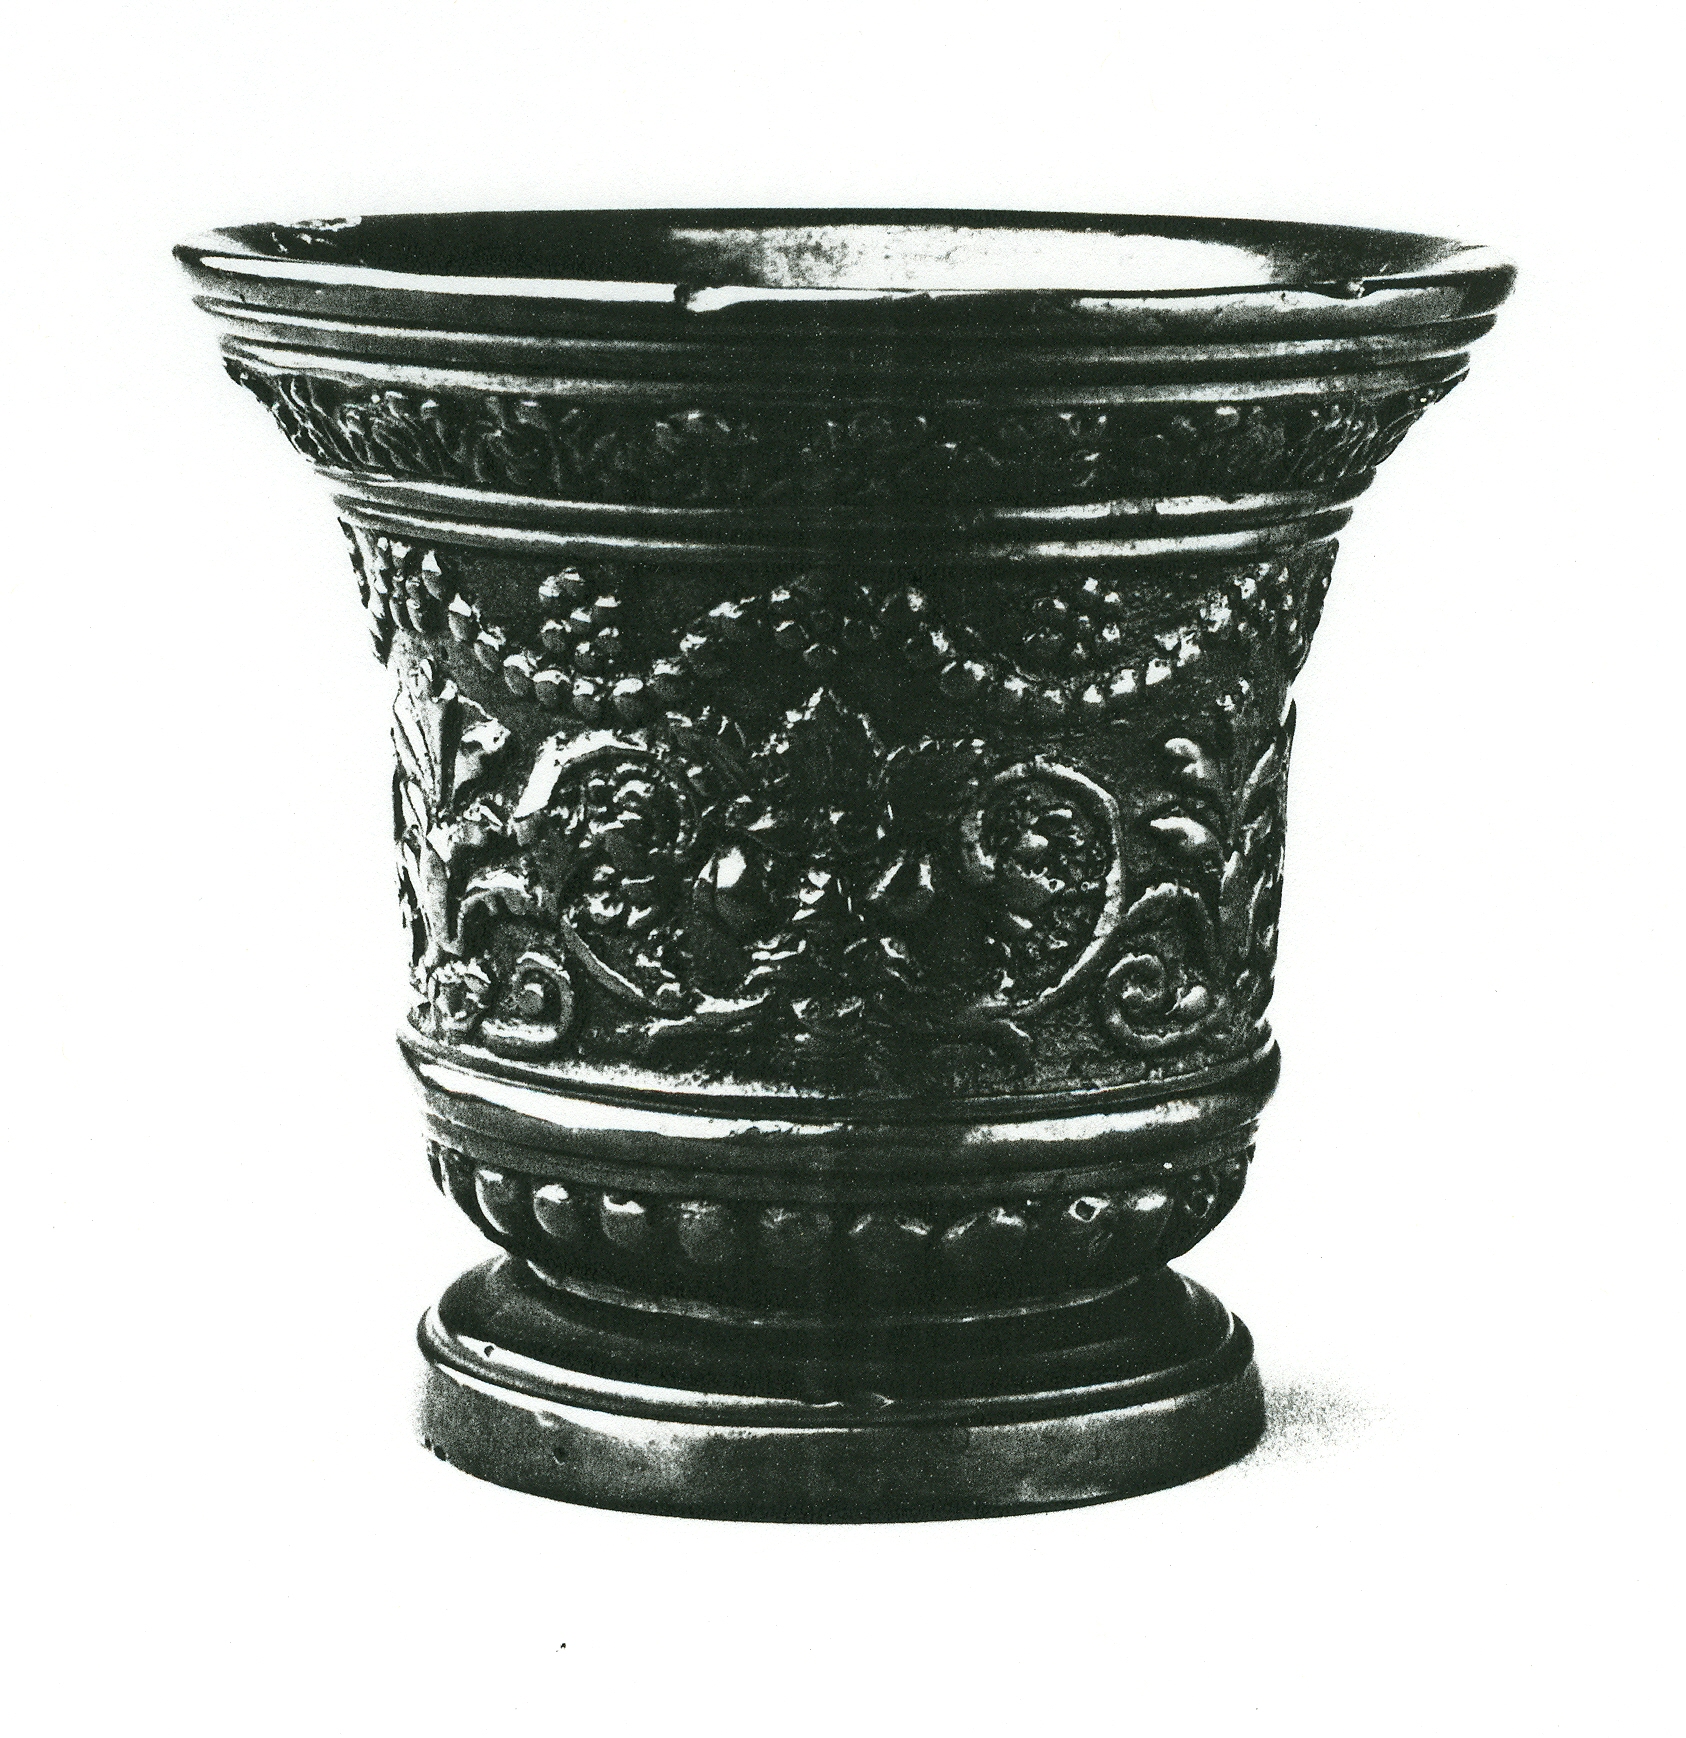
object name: mortar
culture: german or italian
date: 1801-1900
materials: copper alloy, patina